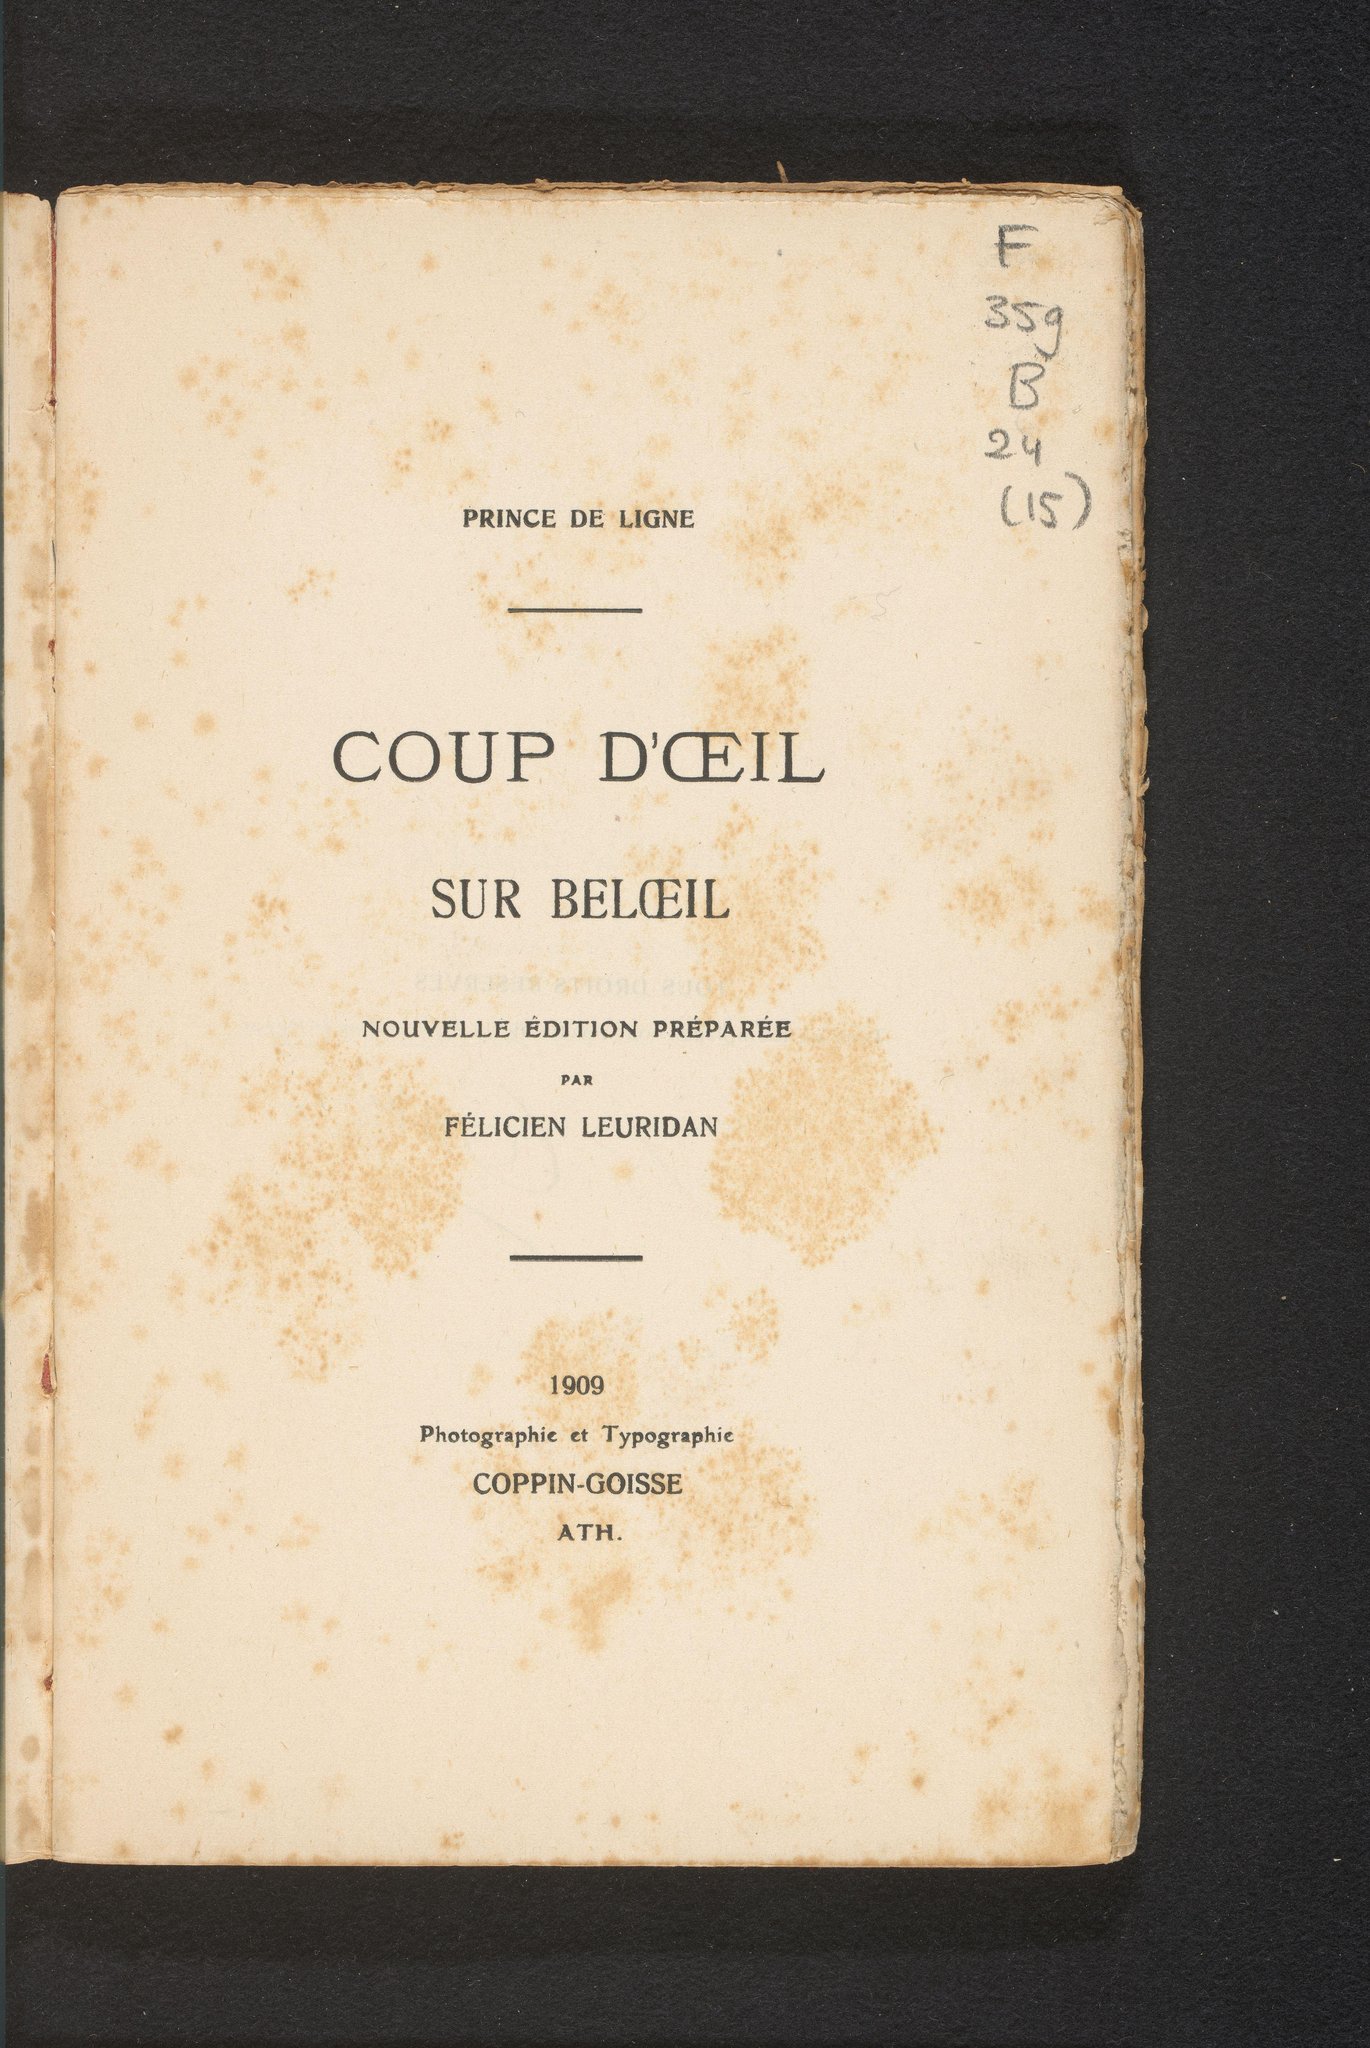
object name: book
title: Coup d'oeil sur Beloeil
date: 1909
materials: paper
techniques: gelatin silver print, printing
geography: ath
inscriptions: date: ‘MAR 1996’, signature: ‘Félicien Leuridant’